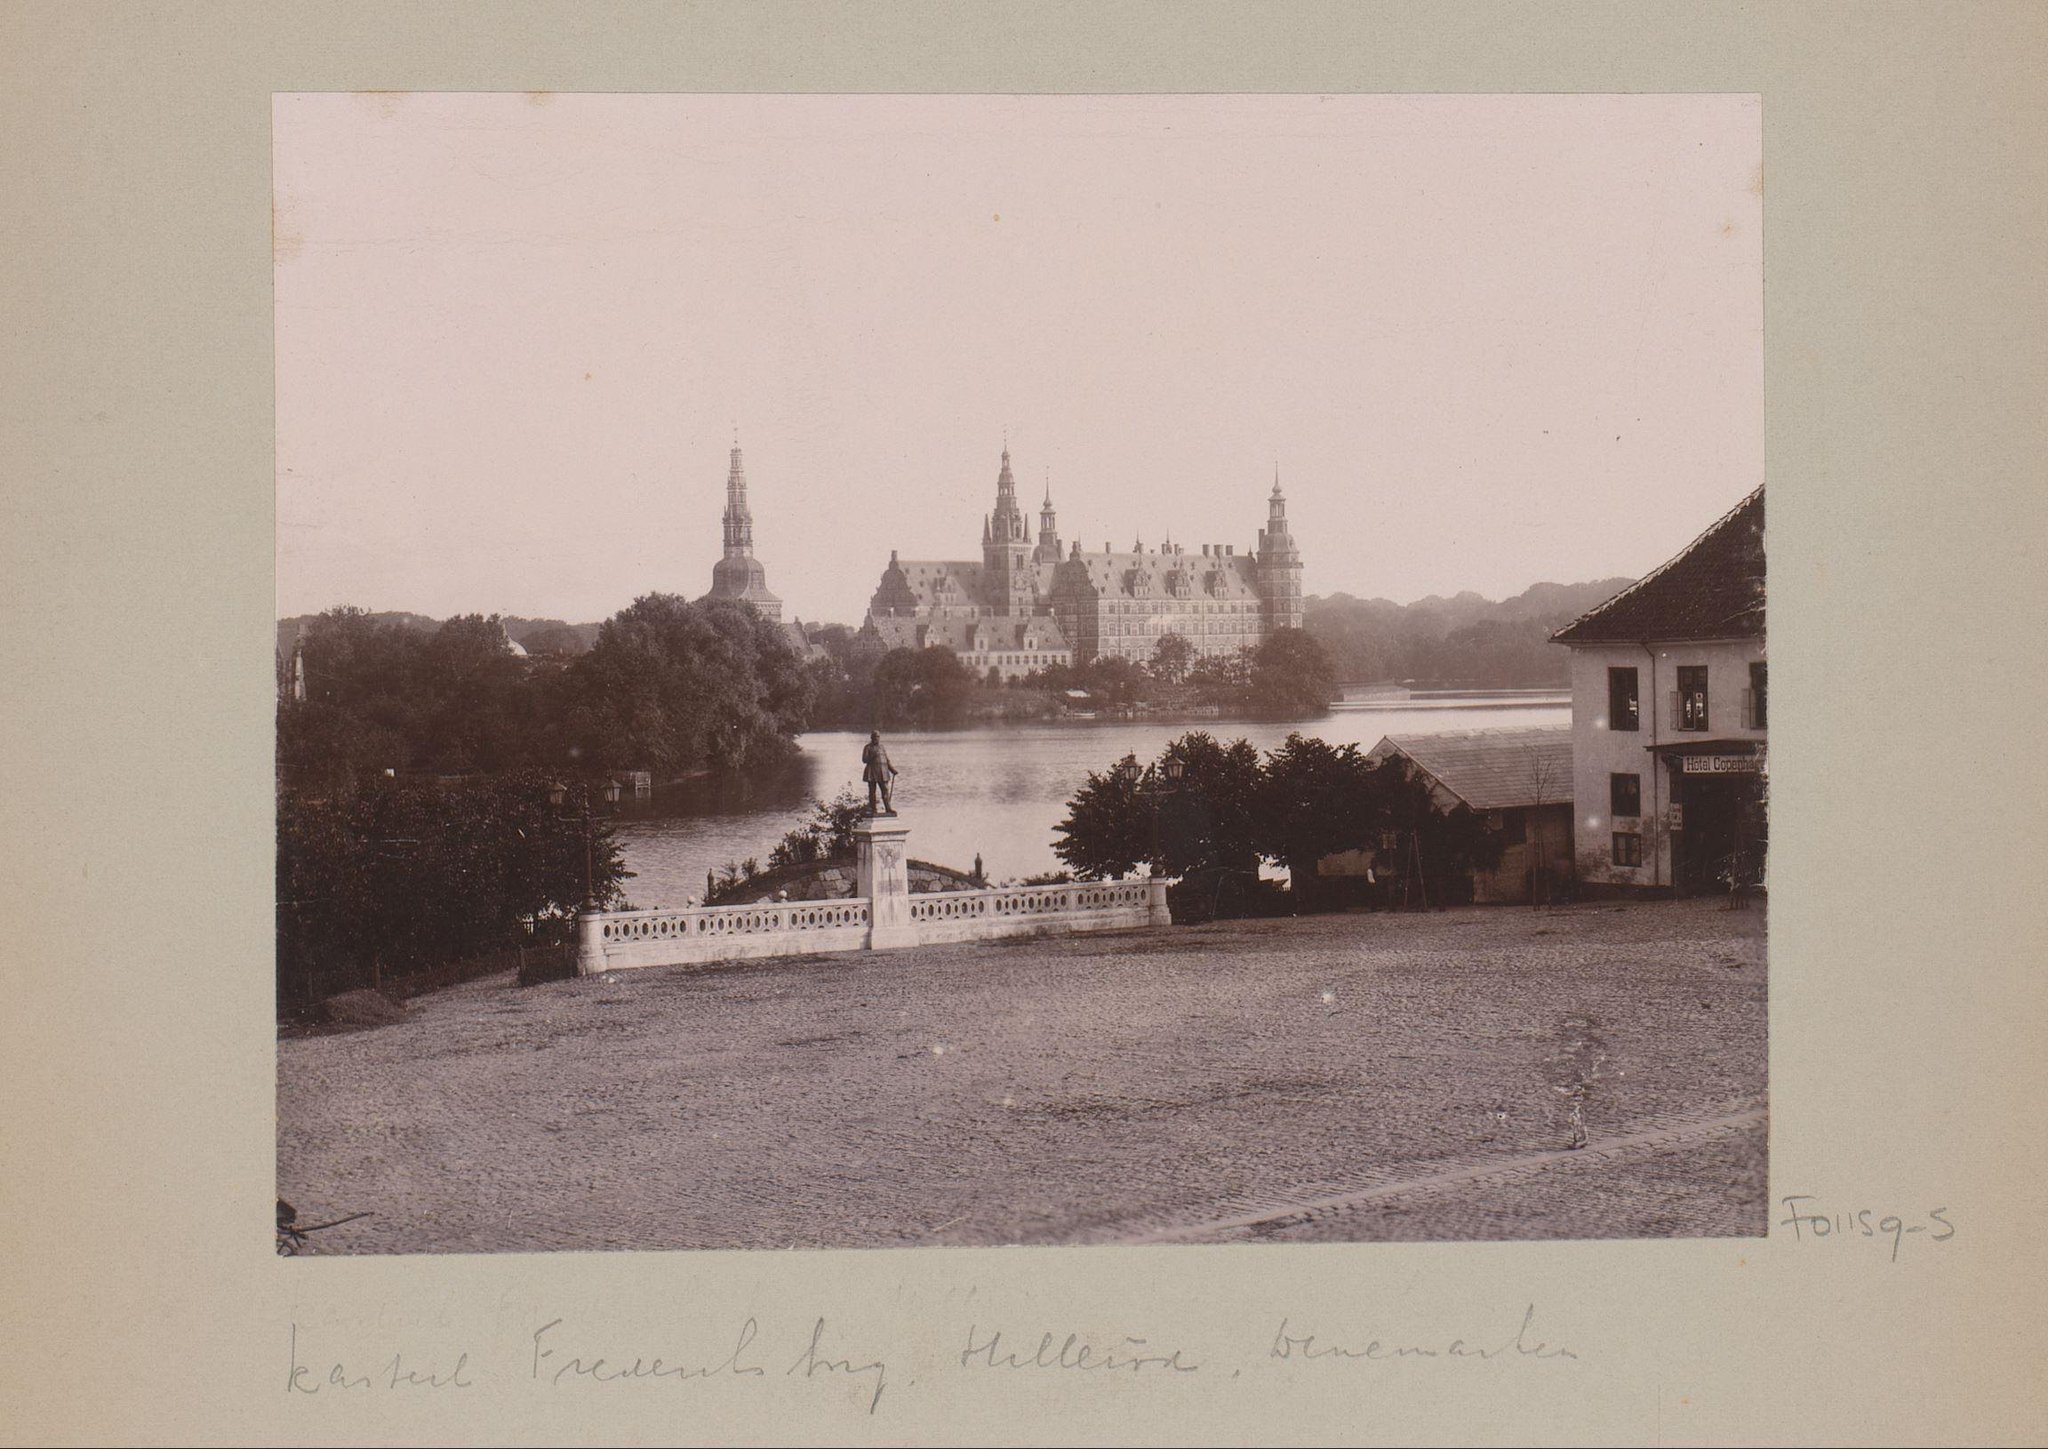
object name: photograph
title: Slot Frederiksborg, gezien over een meer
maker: Anonymous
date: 1880-1900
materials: photographic support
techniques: collodion silver print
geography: hillerød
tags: castle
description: Onderdeel van Reisalbum met opnames van bezienswaardigheden in Zweden, Noorwegen, Denemarken, Beieren, Milaan en Parijs.